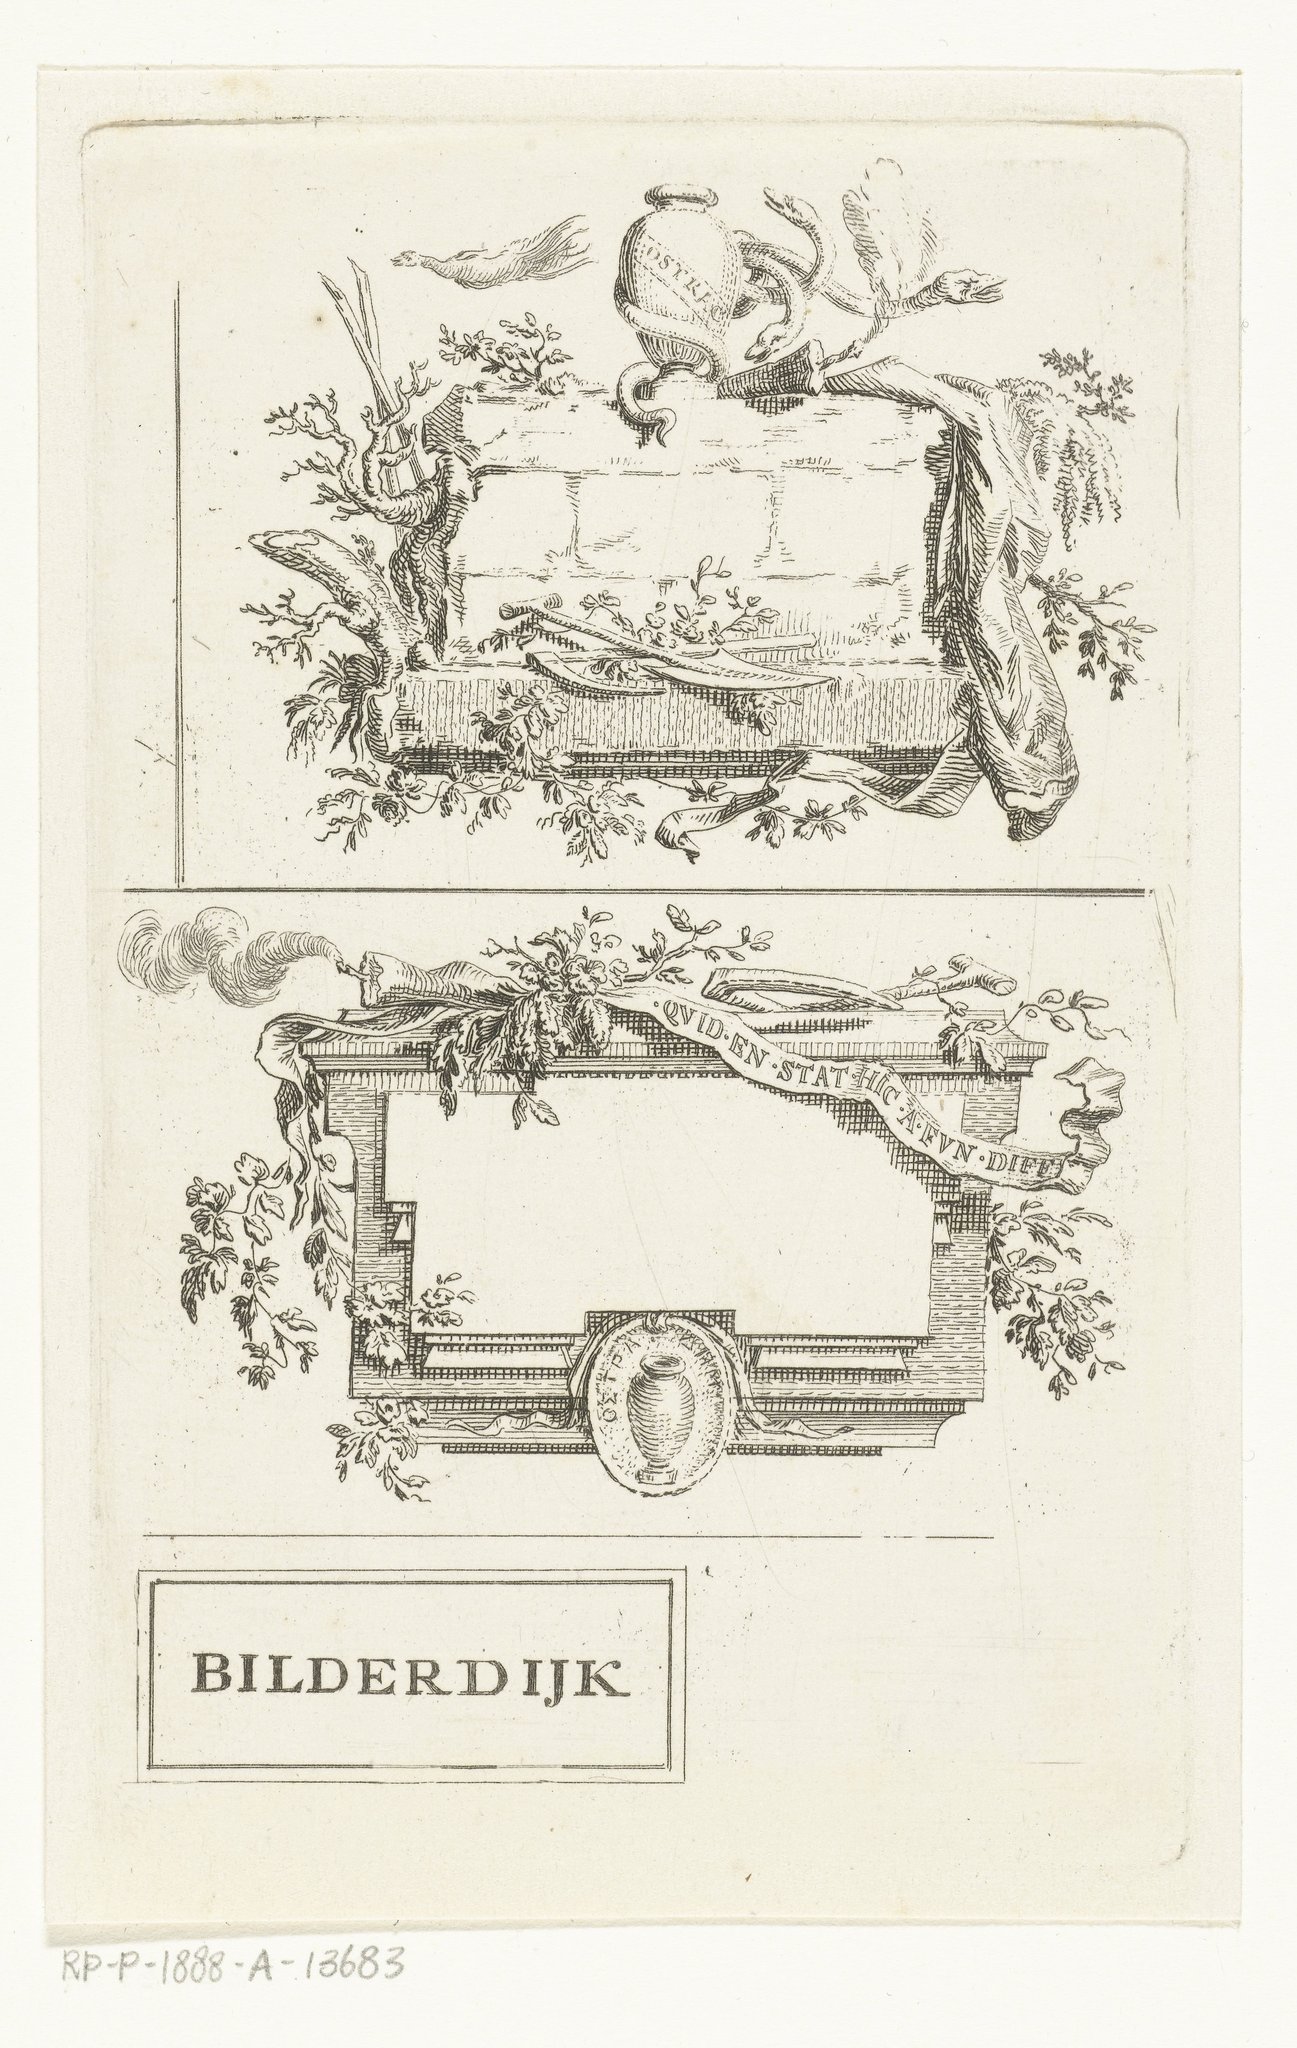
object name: vignette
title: Blad met drie vignetten waaronder naam Bilderdijk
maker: willem bilderdijk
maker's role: draughtsman, print maker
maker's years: 1756-1831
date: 1766-1831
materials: paper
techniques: etching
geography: netherlands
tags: torch, agricultural implements: spade, urn, vignette, tools, aids, implements ~ crafts and industries: pickaxe, epitaph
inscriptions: collector's mark: Lugt 2228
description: Blad met drie vignetten boven elkaar geplaatst: begroeid stenen muurtje of graf en daar bovenop een urn met kronkelende slangen, zowel op het eerste als tweede vignet zijn een schop en houweel weergegeven, bij het tweede liggen ze bovenop een grafmonument naast een gedoofde fakkel en band met opschrift quid en stat hic a fun diff, de lijst van de epitaaf is gedecoreerd met een schild met urn. Het derde vignet draagt de naam van Bilderdijk.